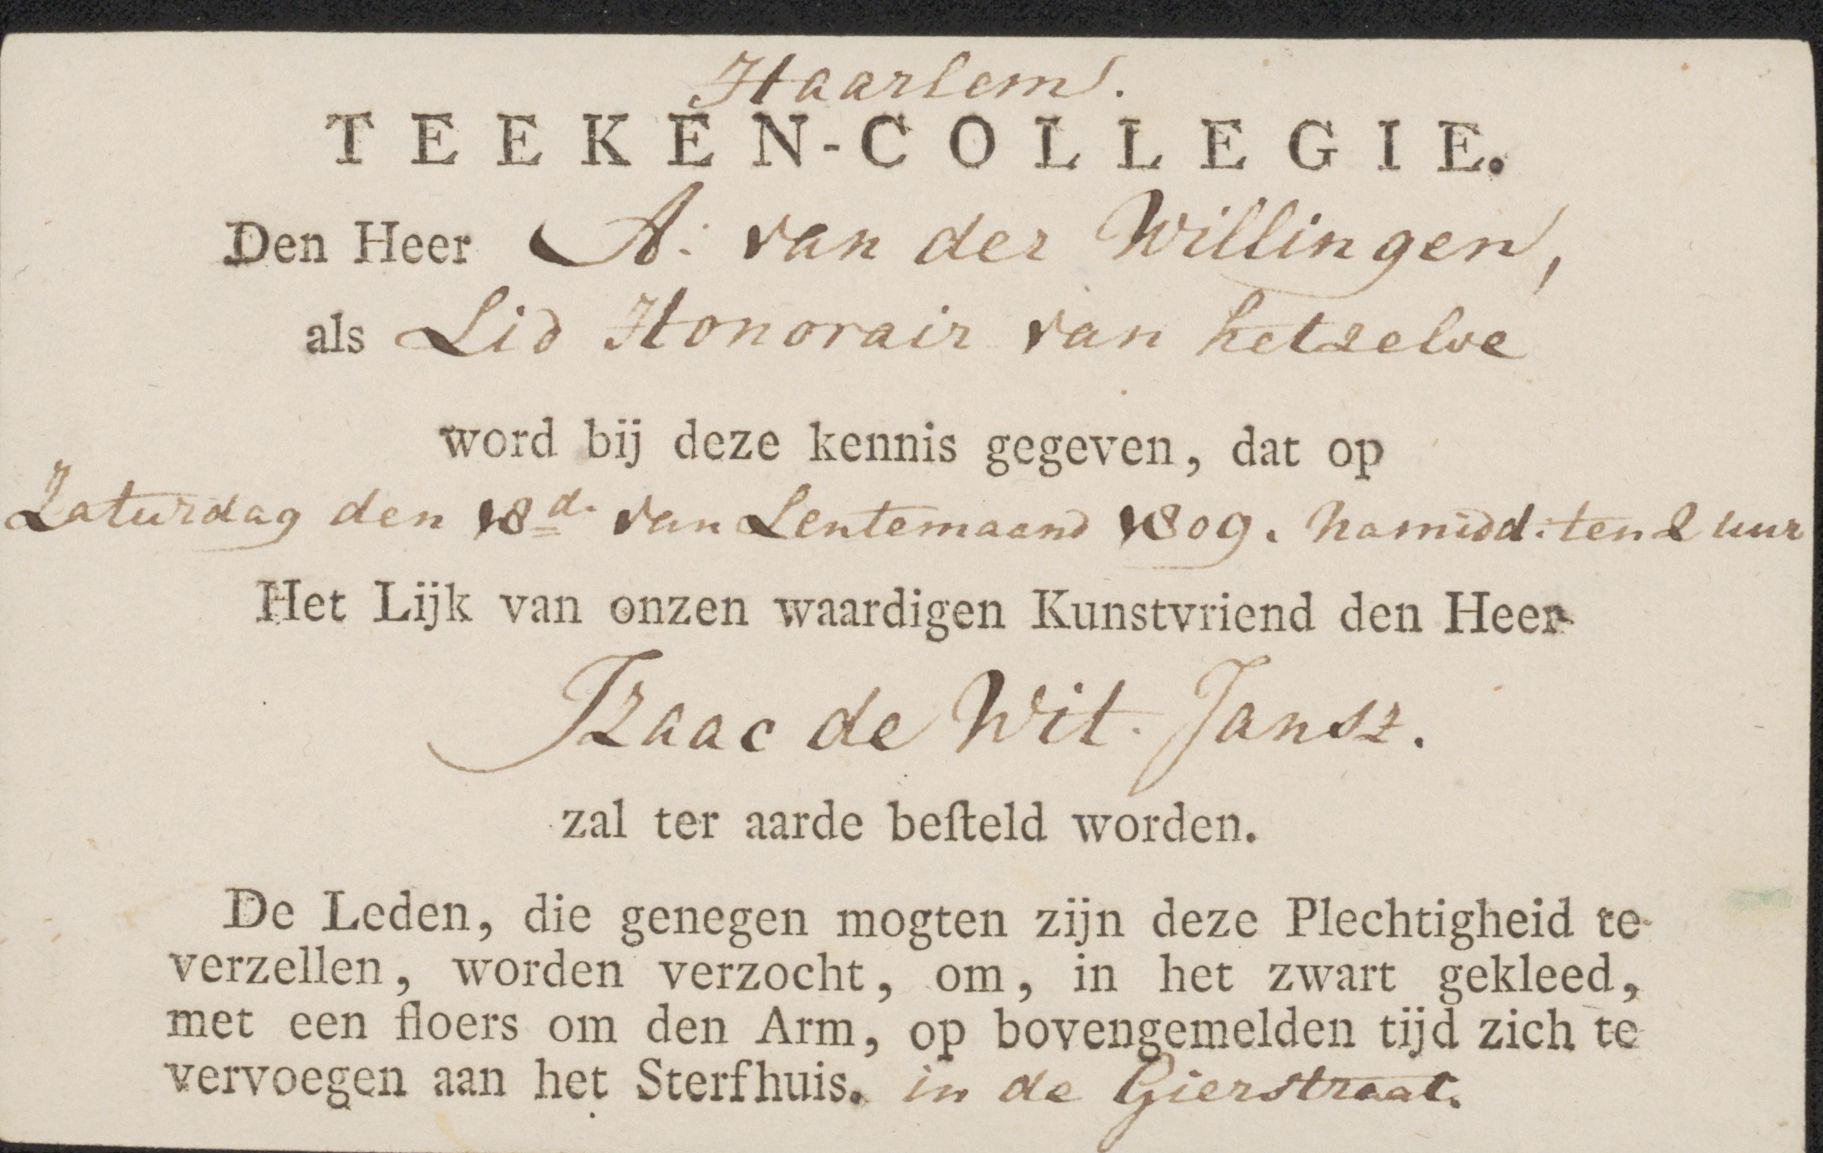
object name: overlijdensbericht, overlijdensadvertentie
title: Kennisgeving van de teraardebestelling van Izaak Jansz. de Wit aan Adriaan van der Willigen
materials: ink, paper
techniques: pen, printing, writing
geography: haarlem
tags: amsterdam, haarlem, print maker, draughtsman, publisher, izaak jansz. de wit, rotterdam, adriaan van der willigen